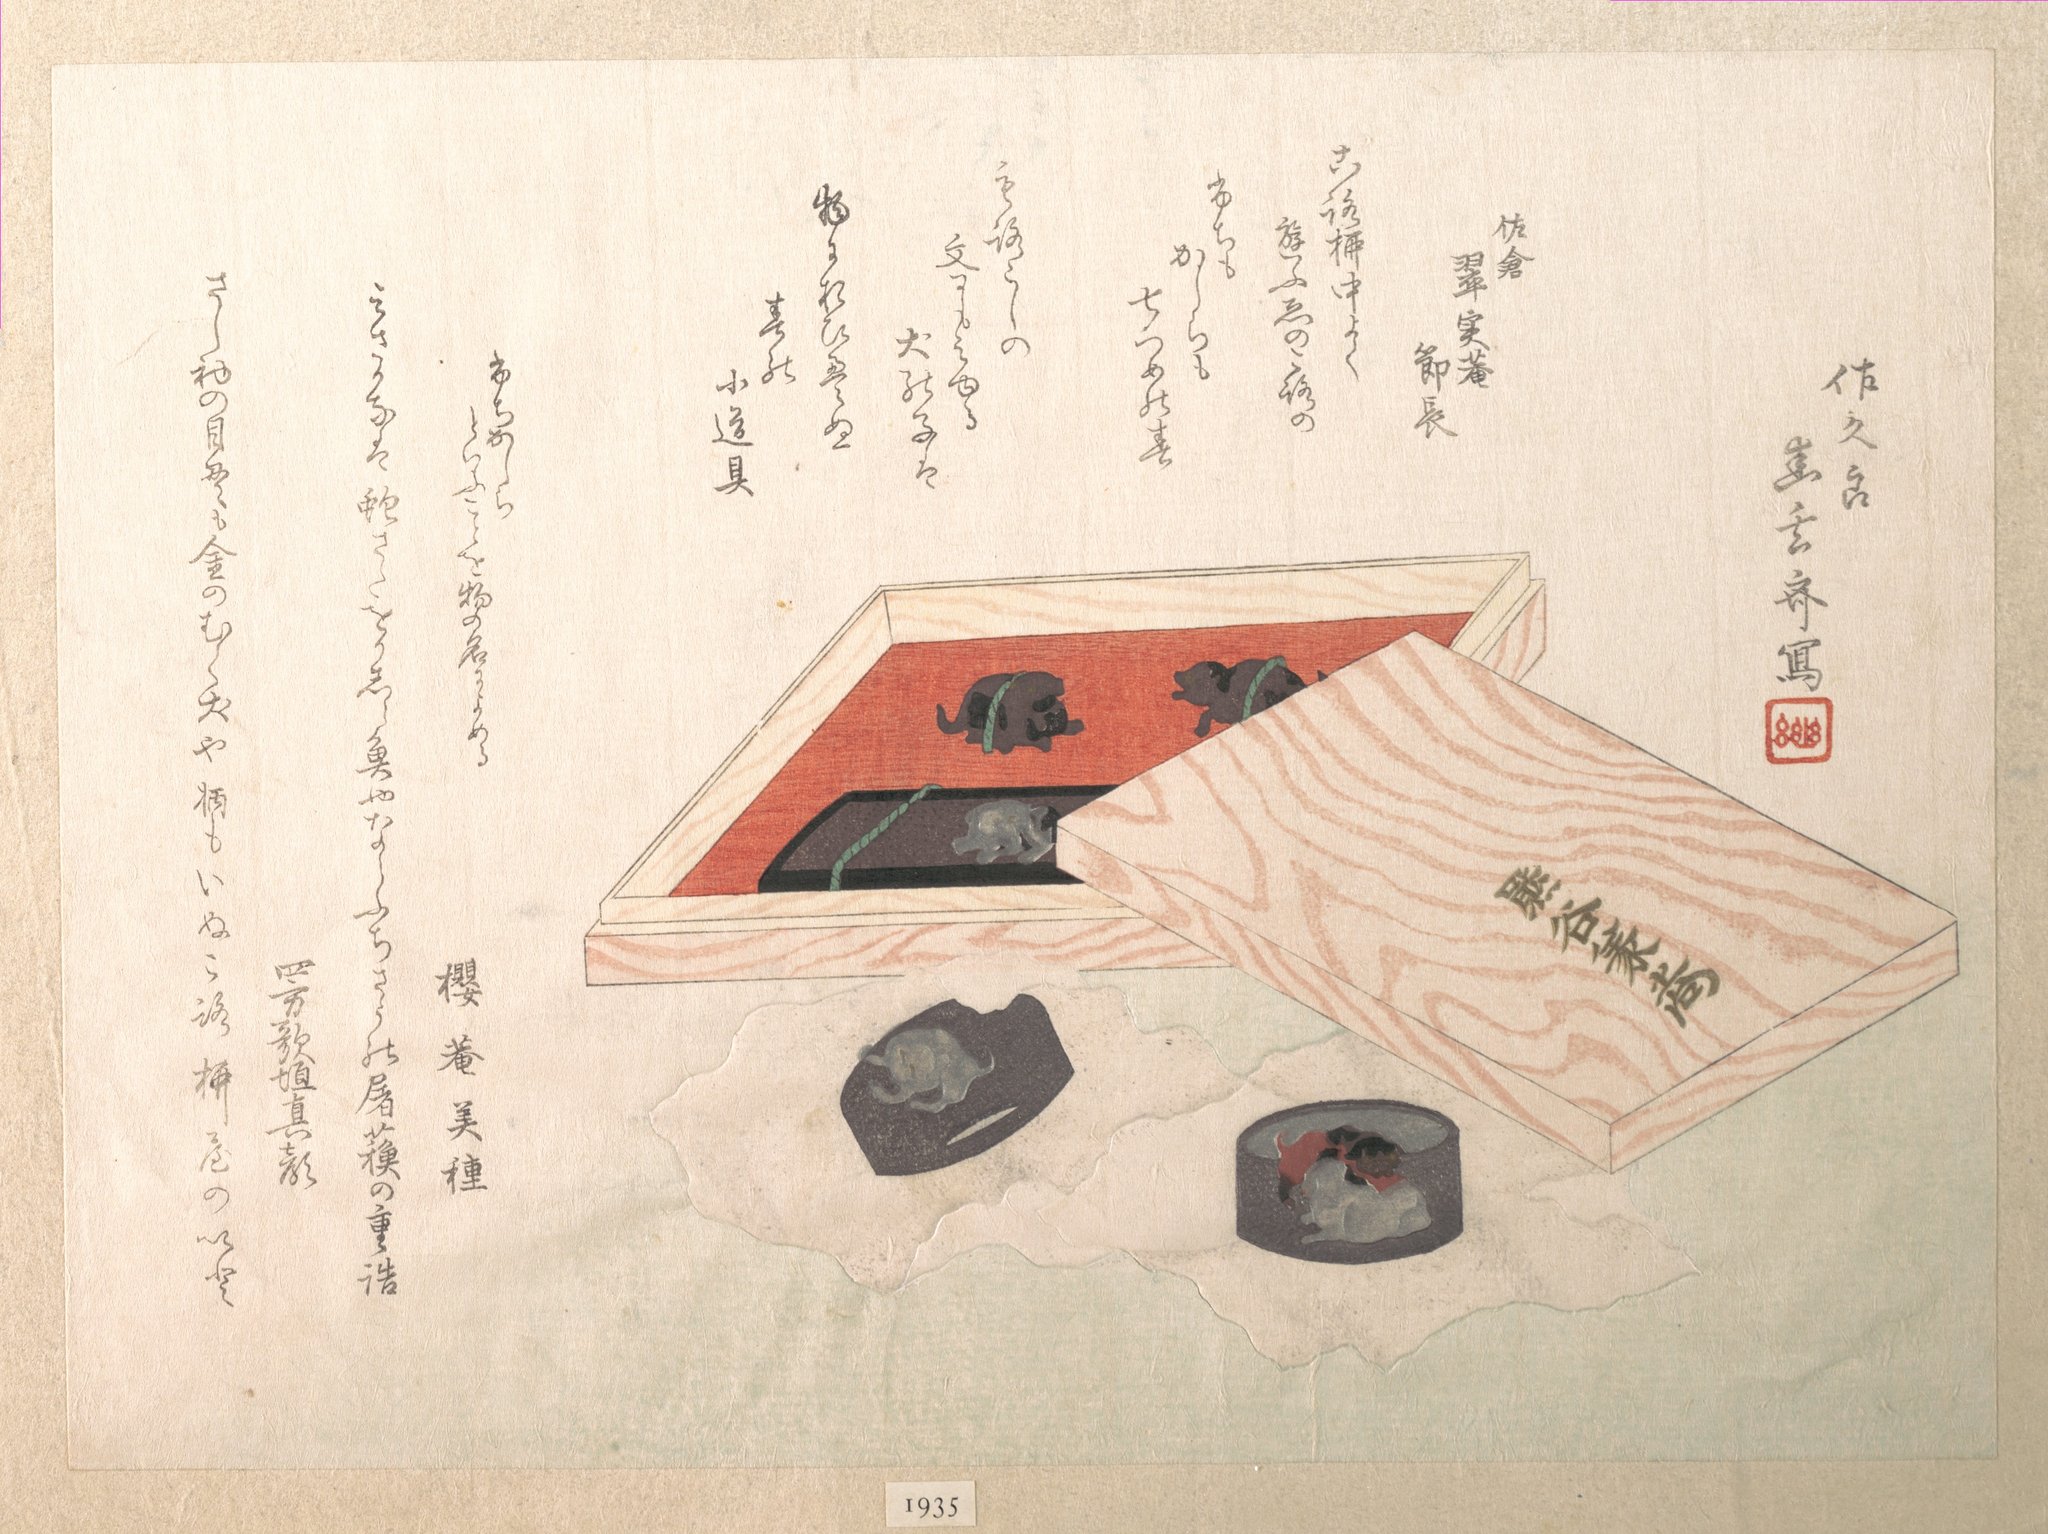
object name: print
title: Set of Sword Fittings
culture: japanese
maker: shungensai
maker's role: artist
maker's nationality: japanese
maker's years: 1700-1899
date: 1768-1868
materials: ink, paper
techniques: surimono, woodblock print